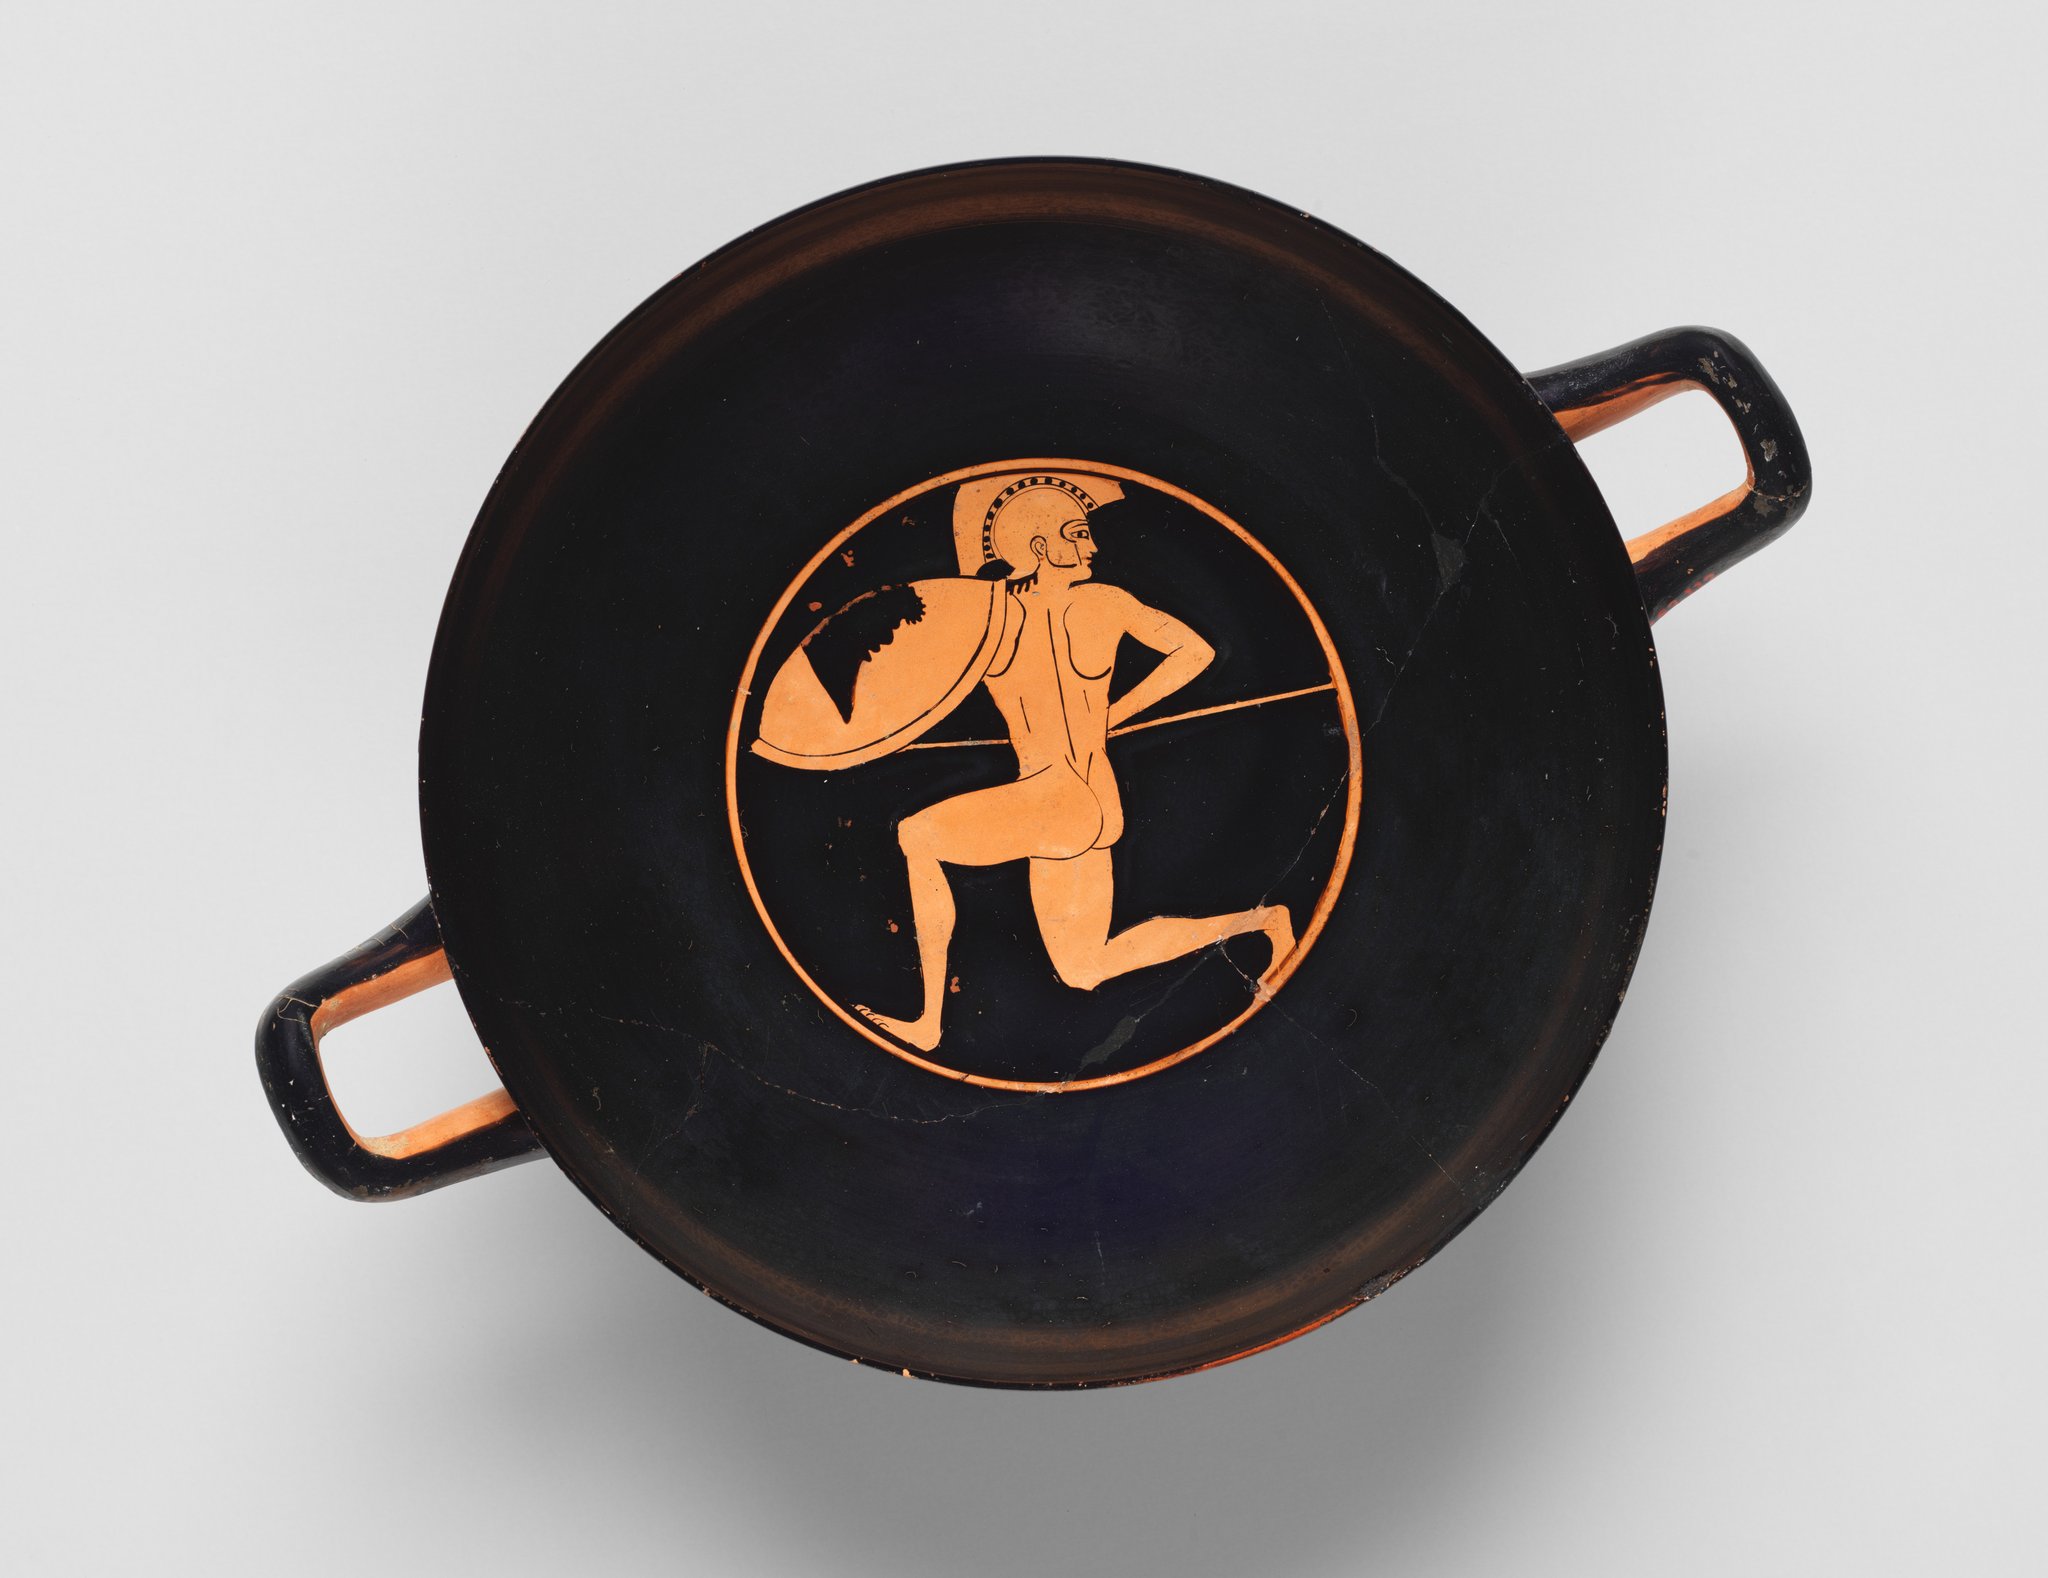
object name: kylix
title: Terracotta kylix (drinking cup)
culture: greek, attic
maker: epiktetos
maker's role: artist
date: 510 BCE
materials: terracotta